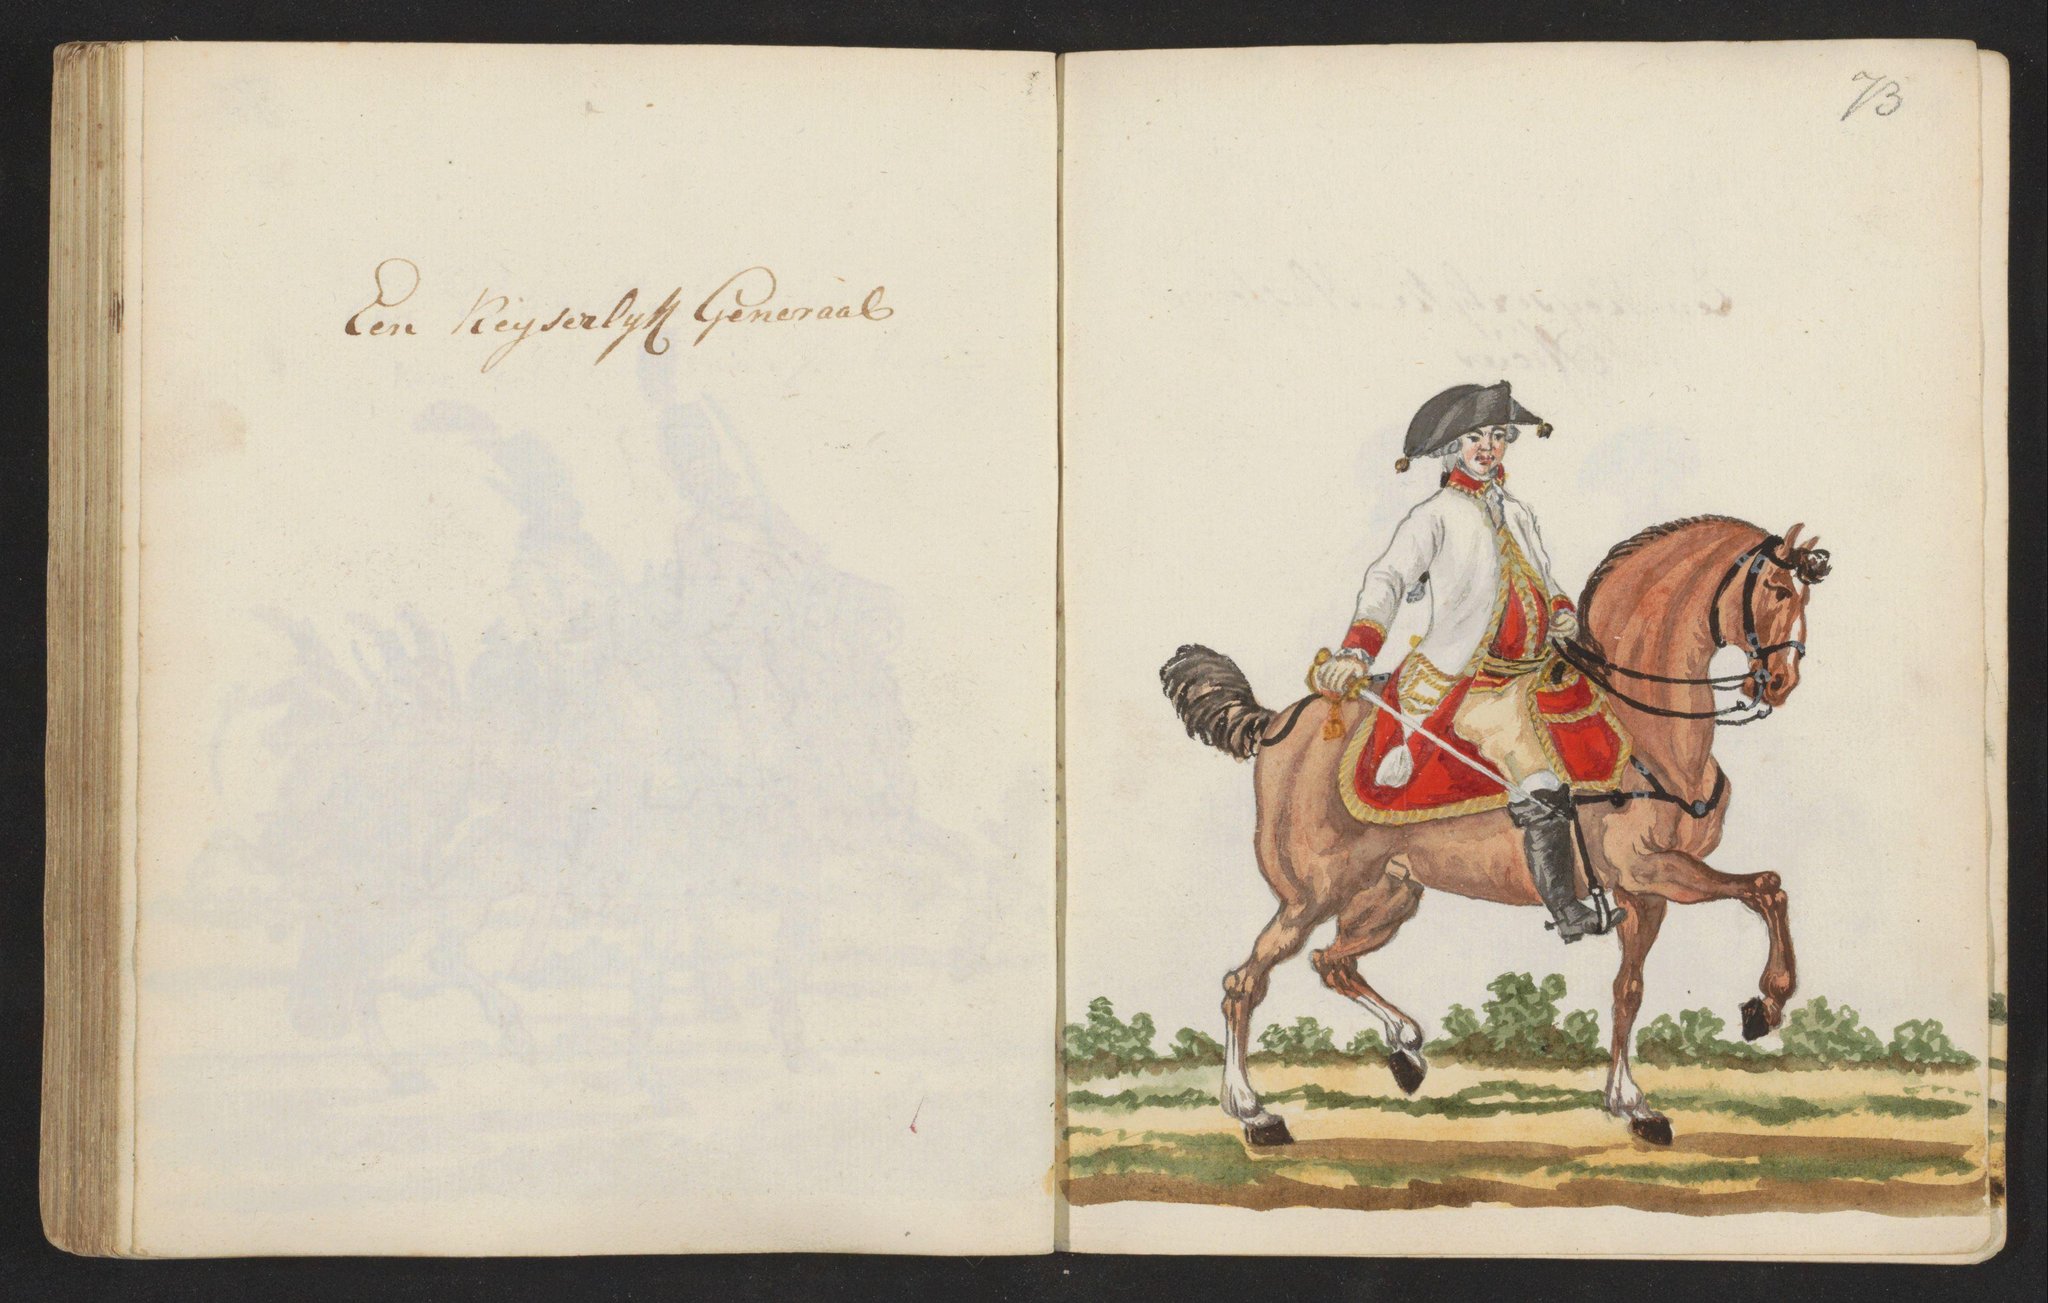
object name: drawing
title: Een Keyserlyk Generaal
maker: s.g. casten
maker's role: draughtsman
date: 1795-1796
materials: paper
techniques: writing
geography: amsterdam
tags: (military) uniforms (+ infantry), patriots (1780-1795)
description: Het uniform van een generaal van de Oostenrijkse keizerlijke troepen, te paard, ca. 1788-1795. Onderdeel van het derde hoofdstuk over de nieuwe uniformen in de periode na het herstel van de prins van Oranje en de komst van de Pruisische troepen in Holland in 1787. In het schetsboek met gekleurde tekeningen van de uniformen van militairen en leden van de schutterij uit de periode 1770 tot 1795-1796.